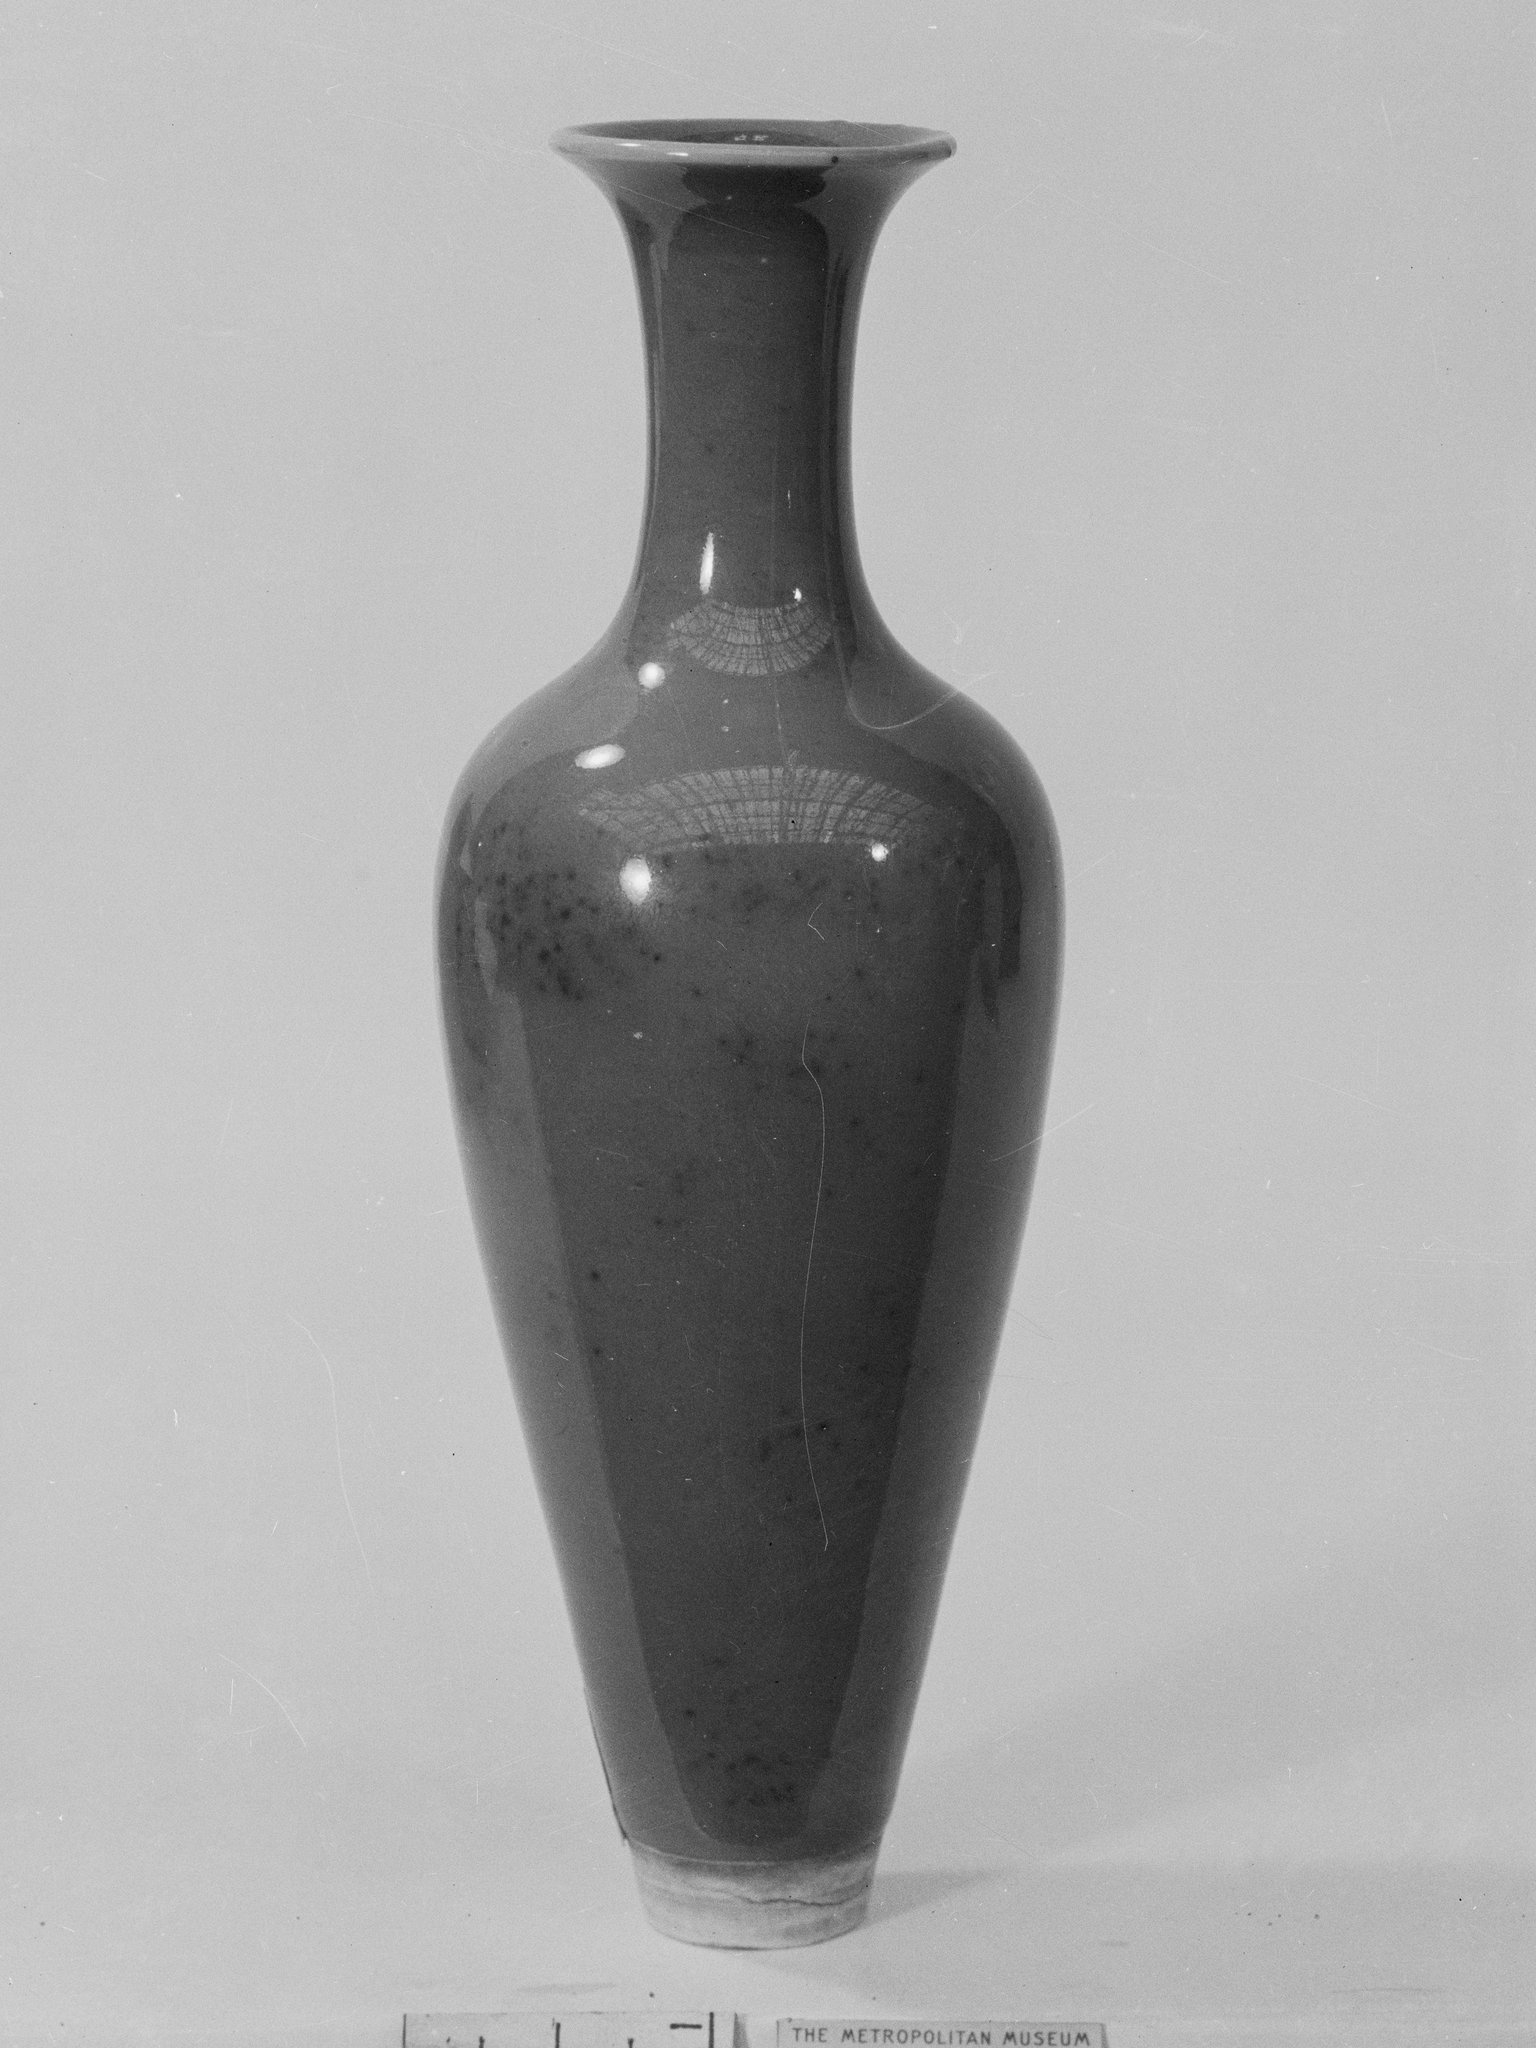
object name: vase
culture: chinese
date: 1662-1722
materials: glaze, porcelain